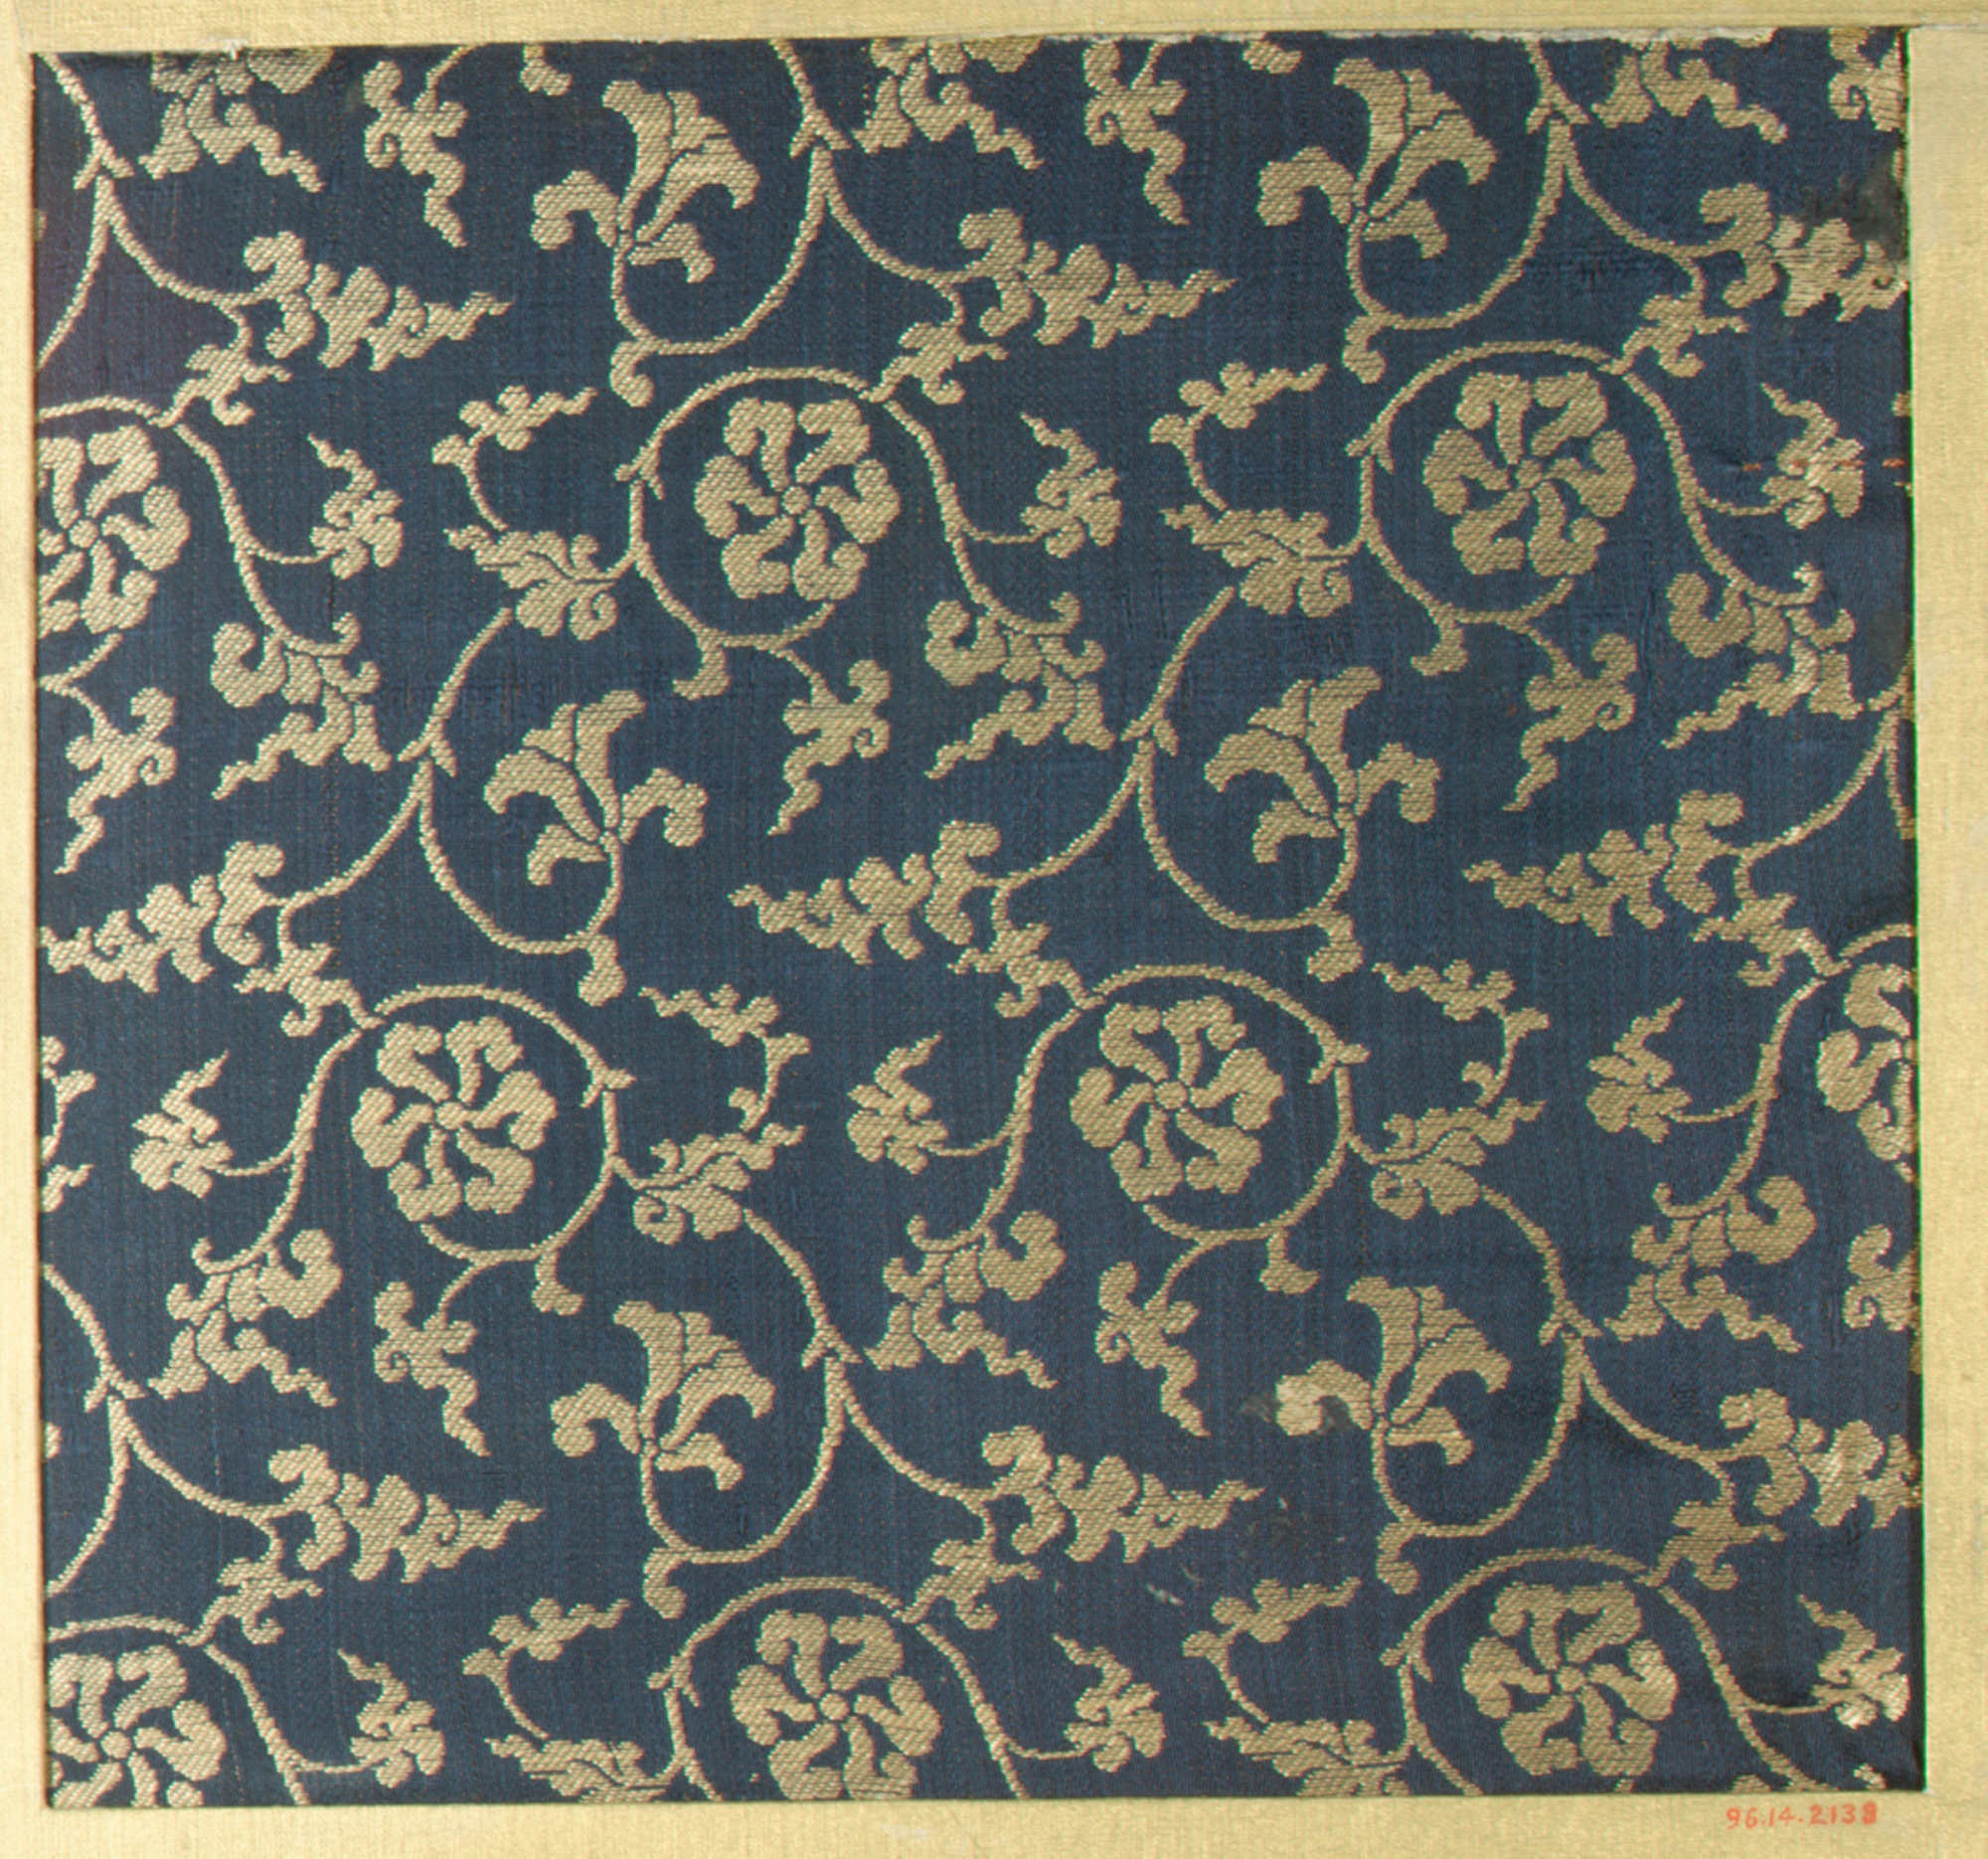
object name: piece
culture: japanese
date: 1701-1900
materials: silk